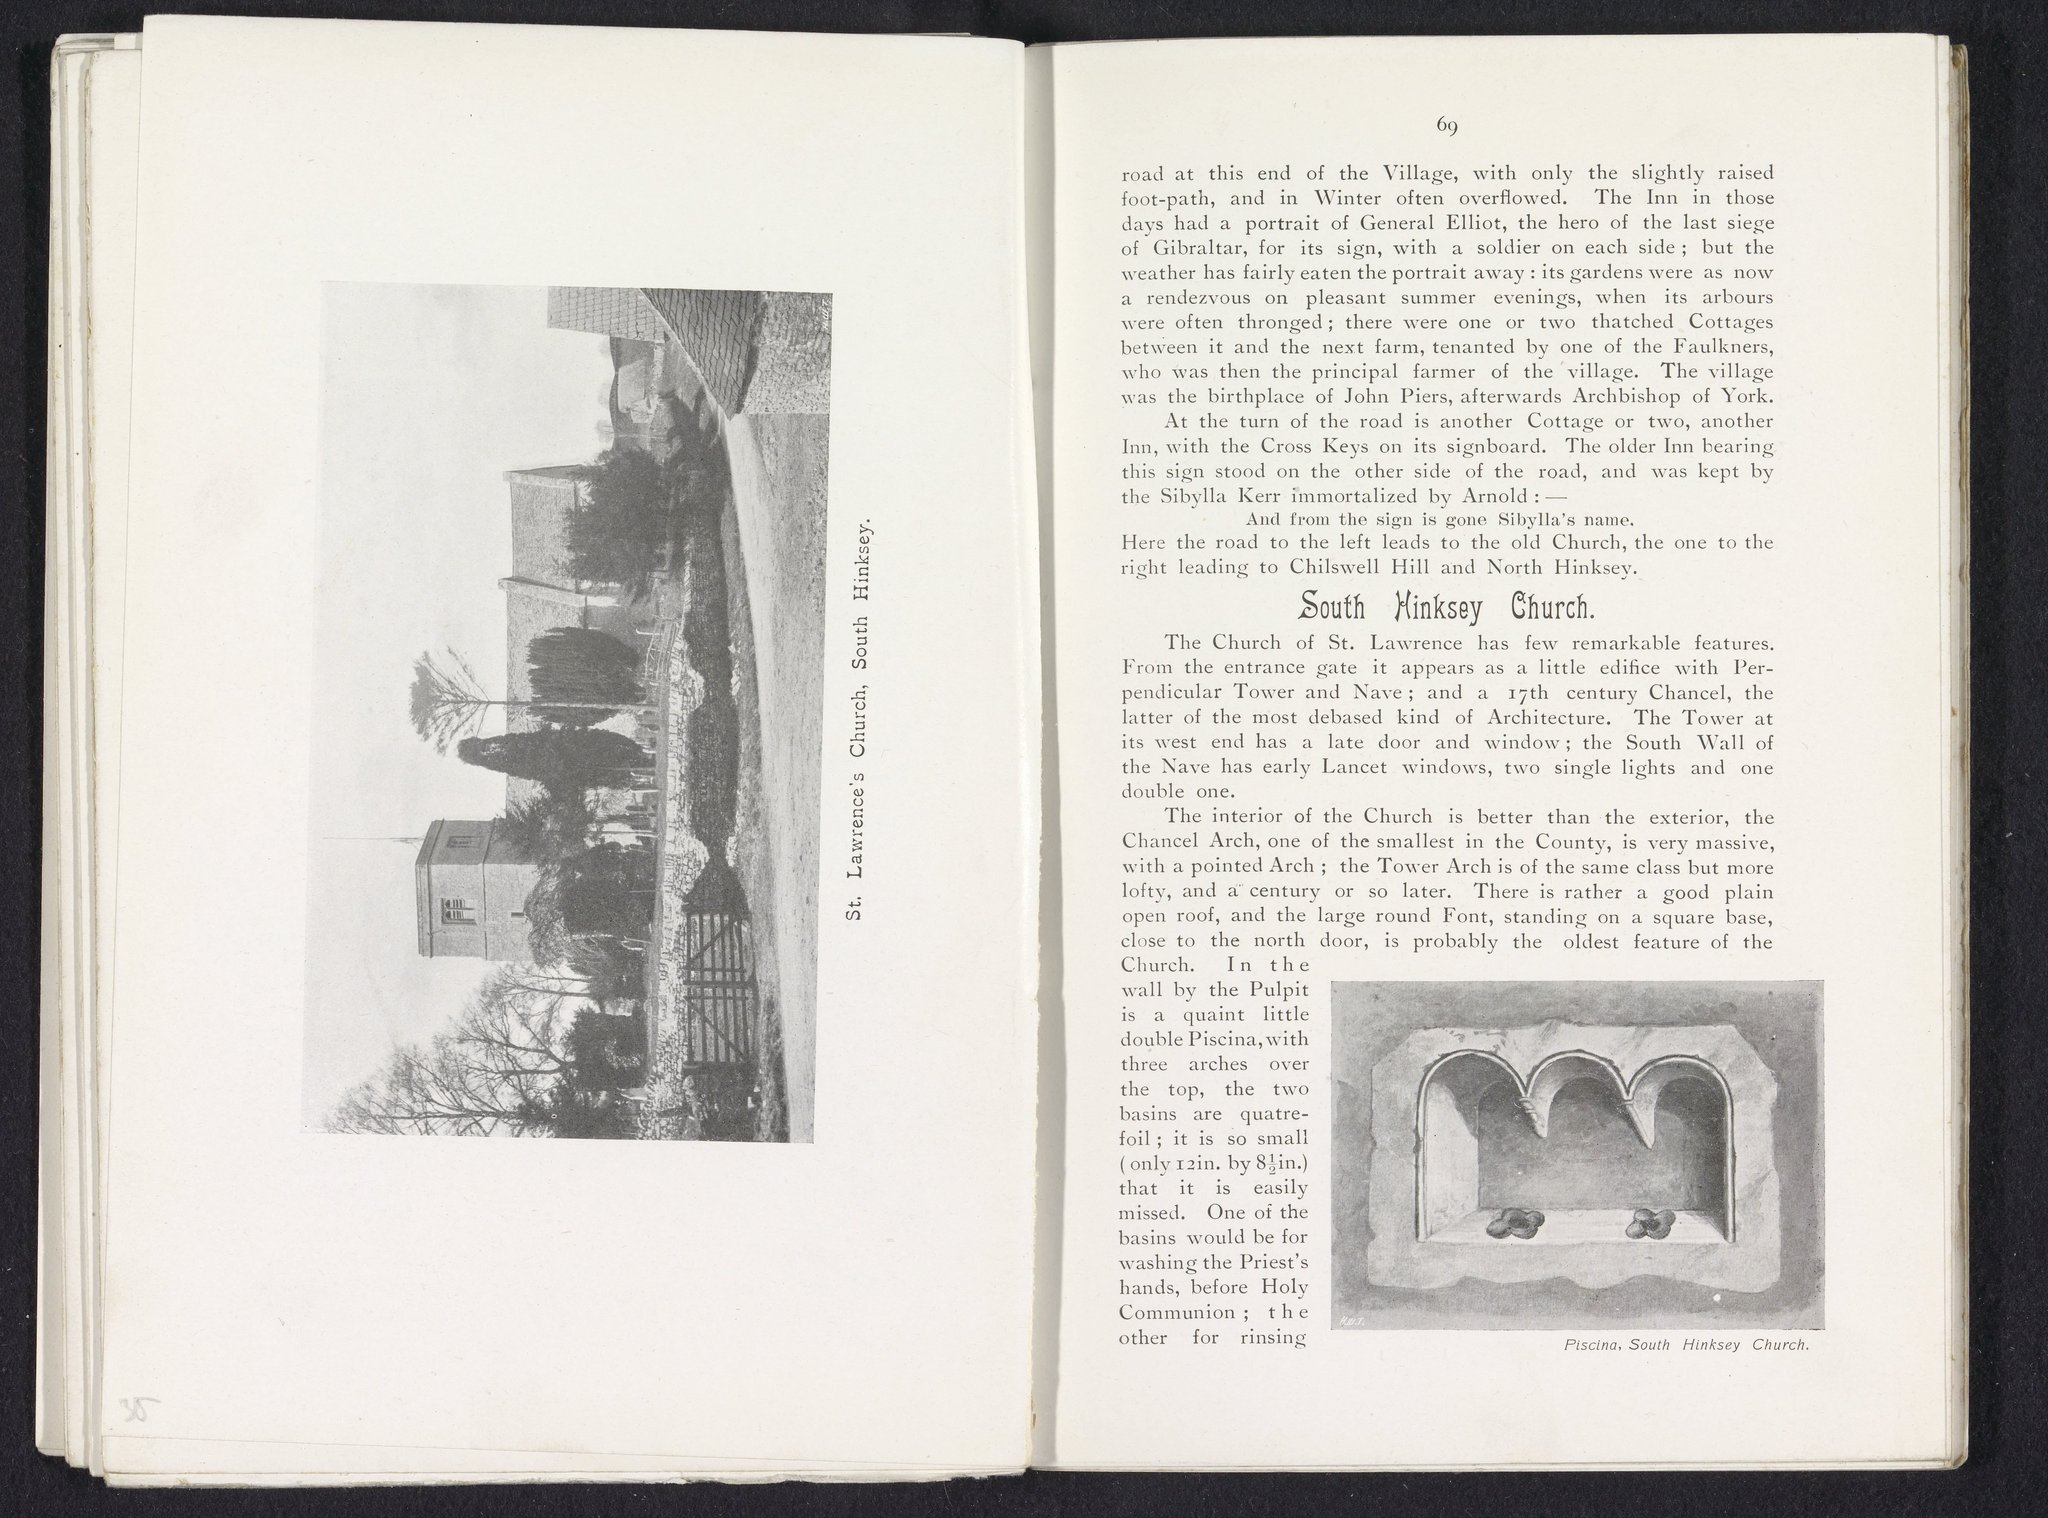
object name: page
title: St Lawrence's Church, South Hinksey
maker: henry w. taunt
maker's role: fotograaf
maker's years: 1842-1922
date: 1907-1912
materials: paper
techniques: autotype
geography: south hinksey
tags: church (exterior)